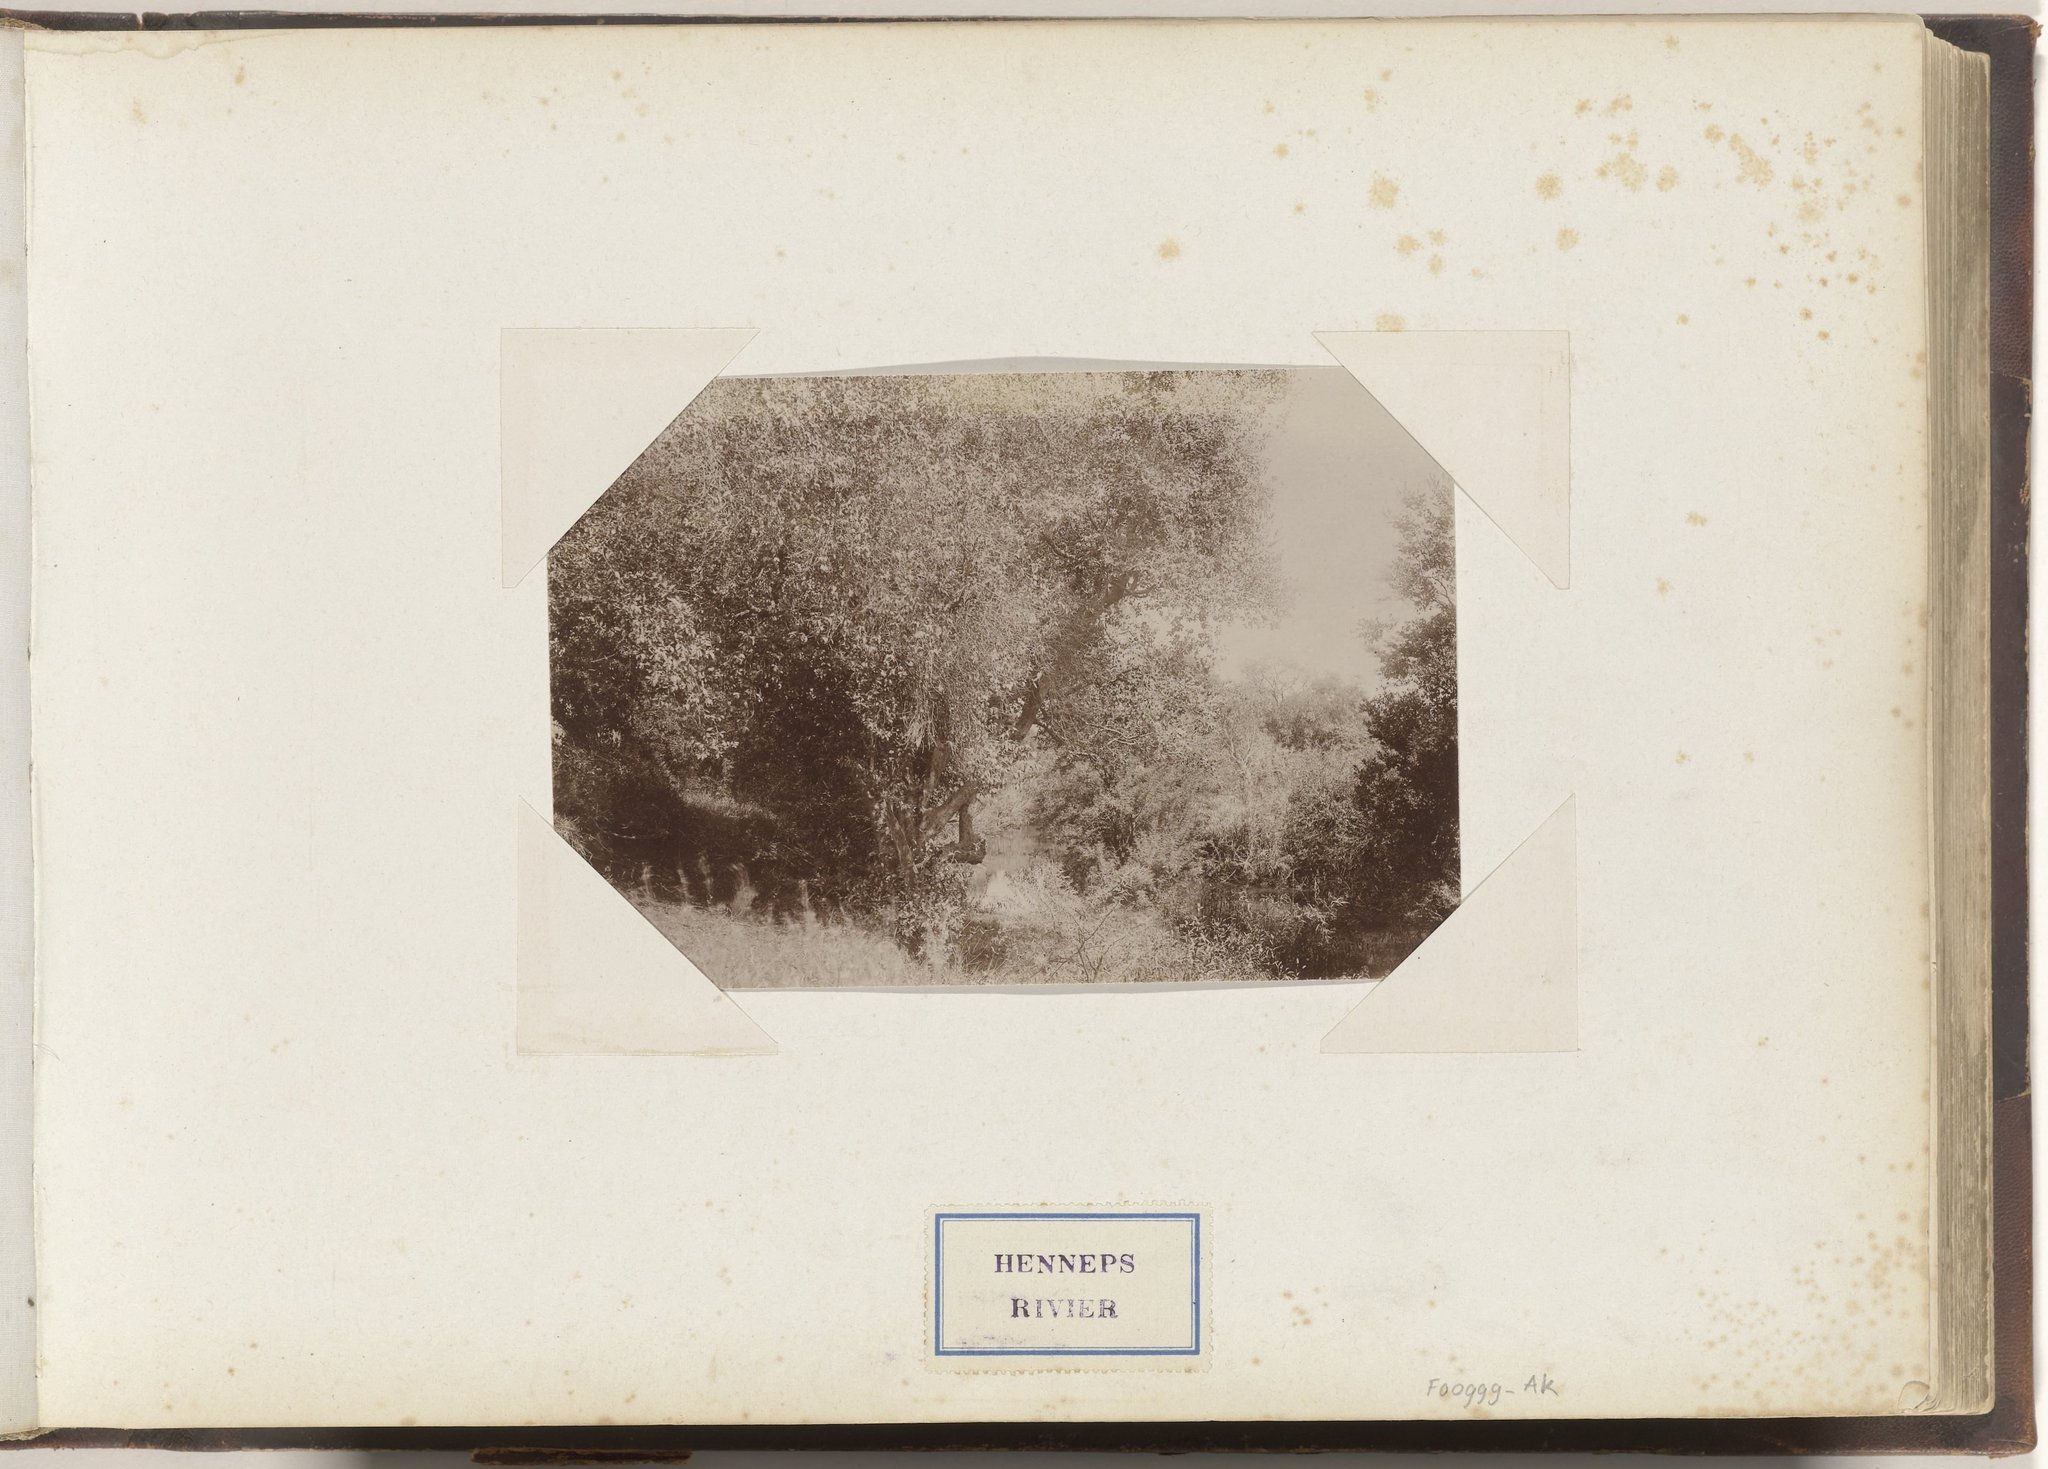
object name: photograph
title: Henneps Rivier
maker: Anonymous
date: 1885-1910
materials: paper, photographic support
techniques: daylight paper print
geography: south africa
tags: trees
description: Onderdeel van Album met 191 foto's van een reis naar en door Zuid-Afrika.